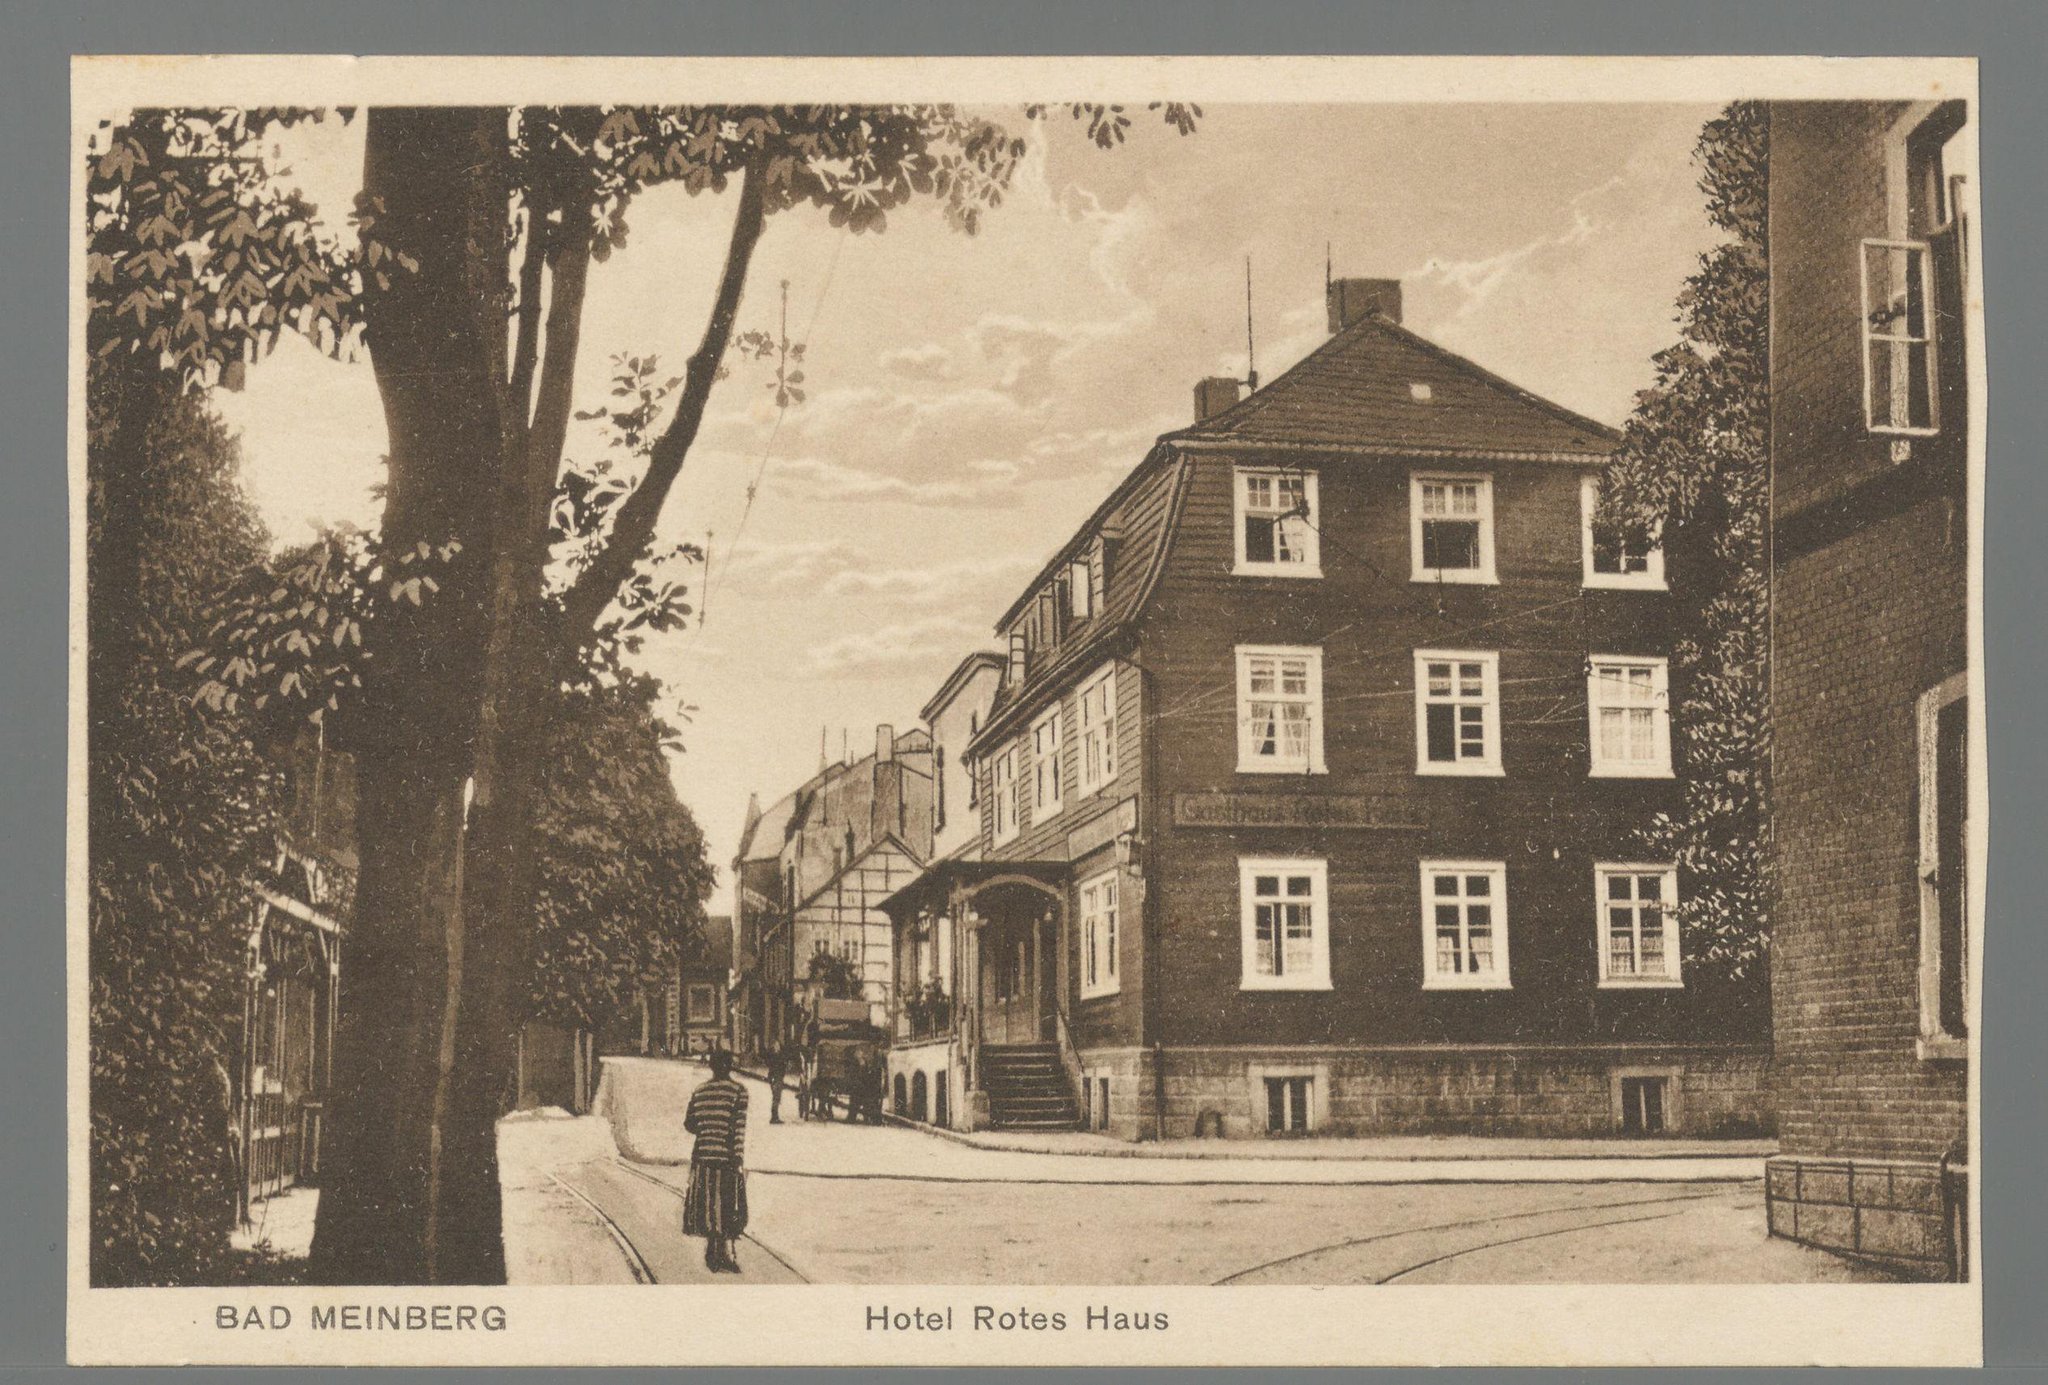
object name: photomechanical print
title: Bad Meinberg. Hotel Rotes Haus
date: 1905-1930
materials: cardboard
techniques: photograph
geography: bad meinberg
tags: street, hotel, hostelry, inn